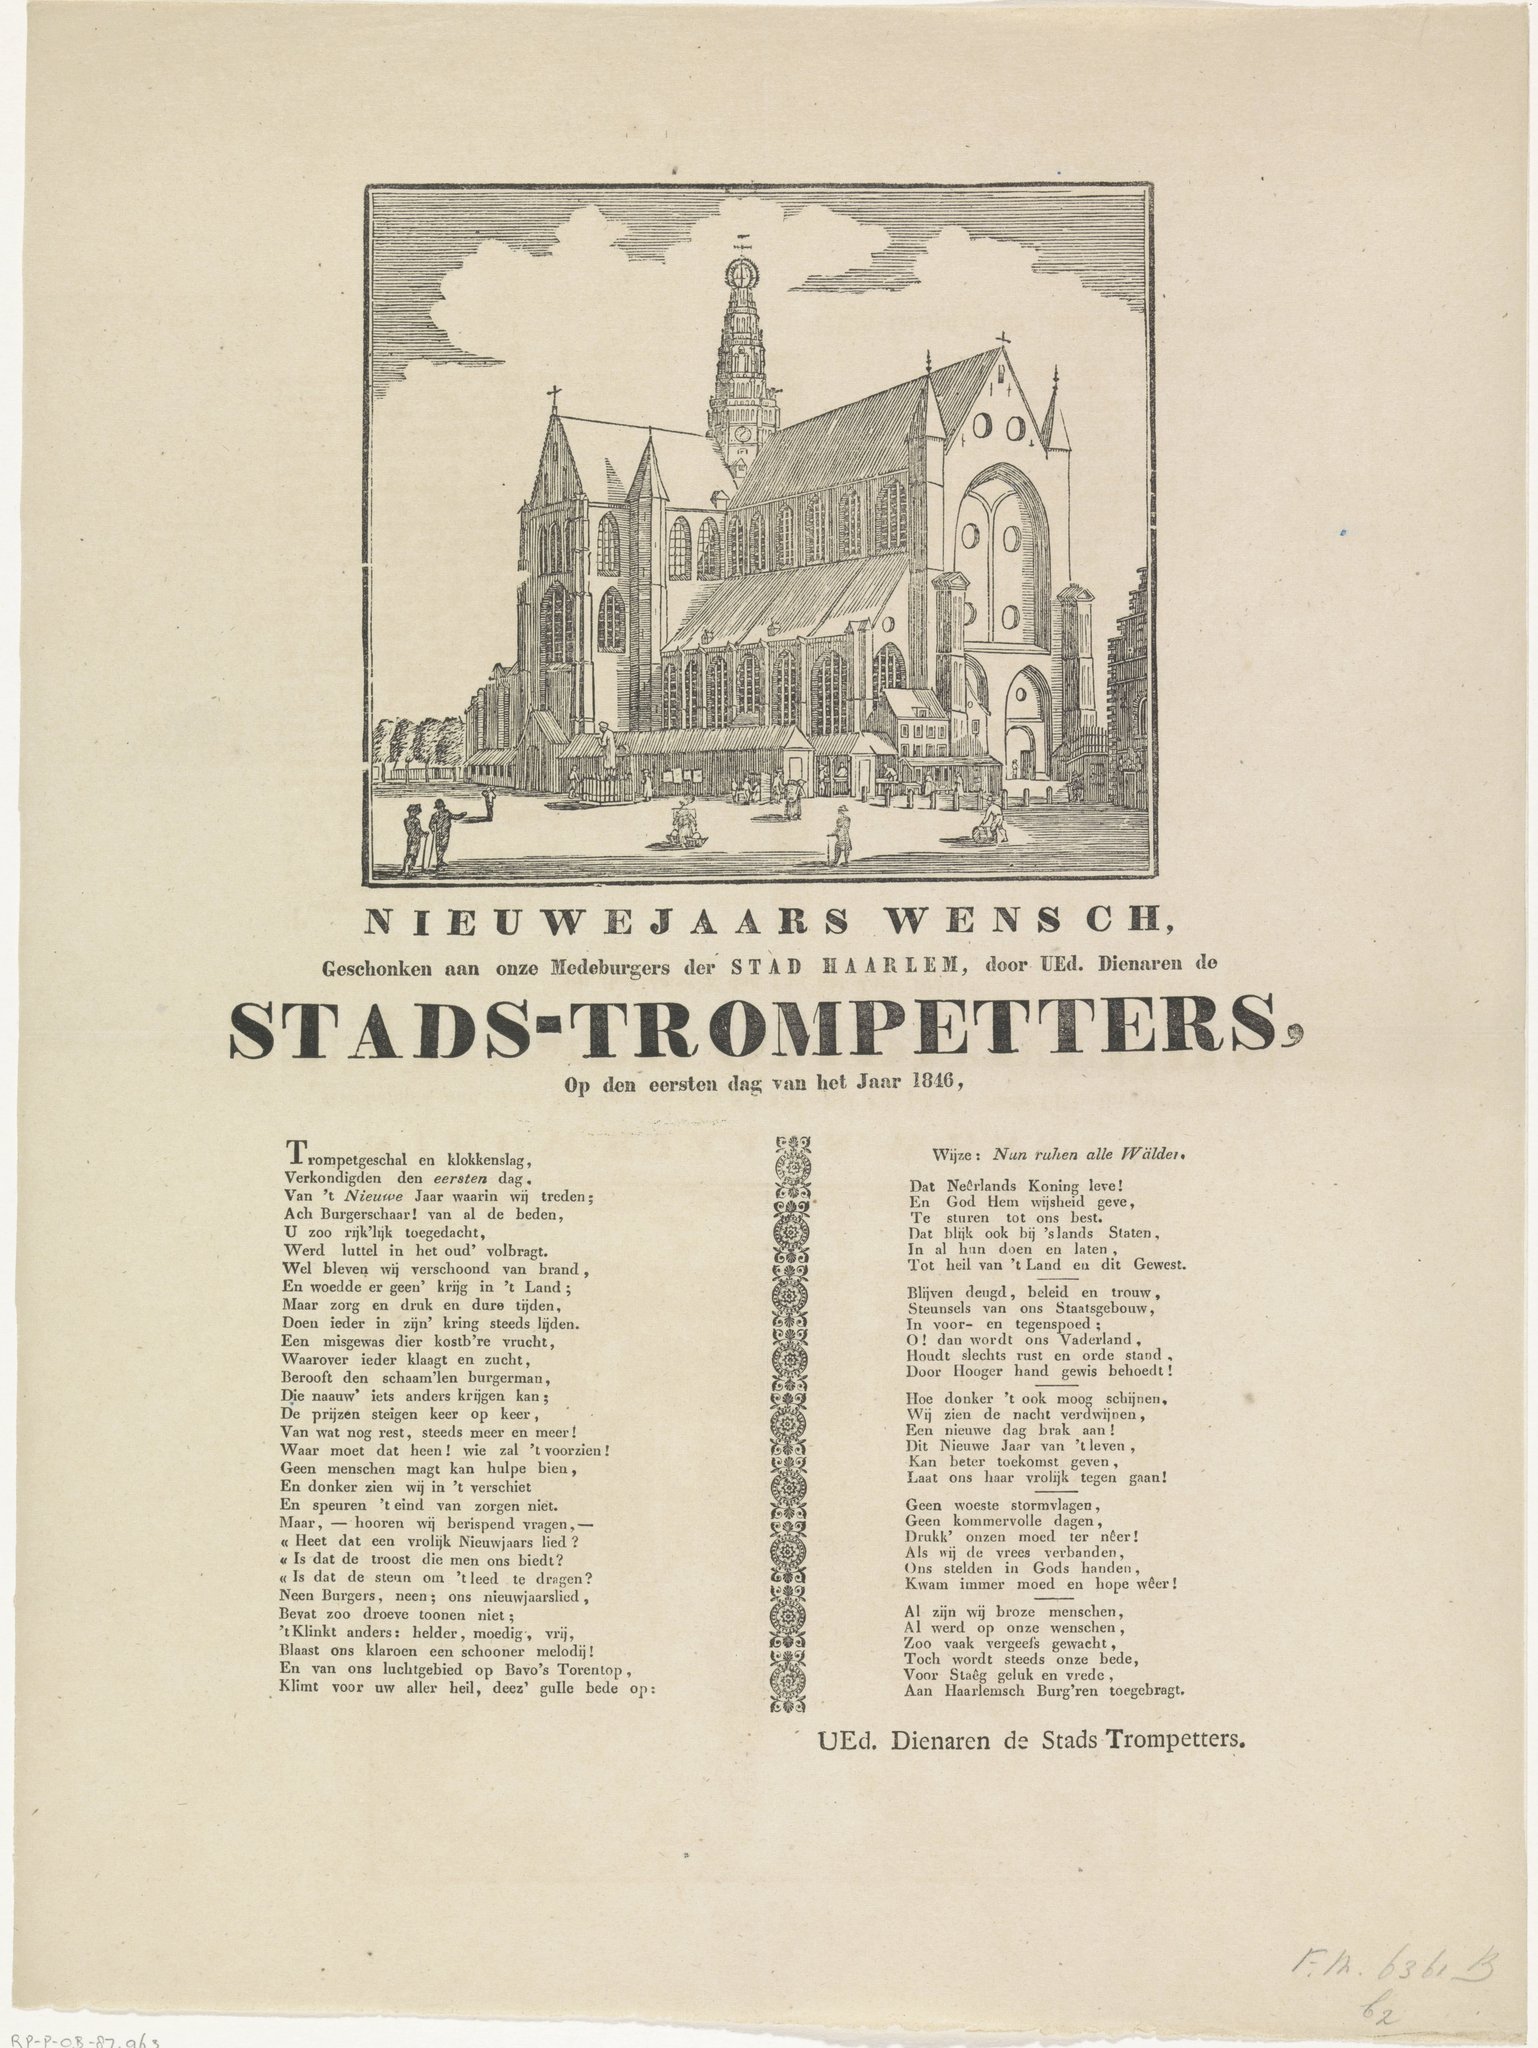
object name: new year card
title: Nieuwjaars Wensch (...) door UEd. Dienaars de Stads-Trompetters (...) 1846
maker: Anonymous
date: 1845-1846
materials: paper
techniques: letterpress printing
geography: haarlem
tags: tower sentry, church (exterior), street, haarlem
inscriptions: collector's mark: Lugt 2228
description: Nieuwjaarswens van de Haarlemse torenwachters (stadstrompetters) voor het jaar 1846. Gezicht op de Grote Markte te Haarlem met een torenwacht op de toren van de Sint-Bavo. Met een vers in twee kolommen.